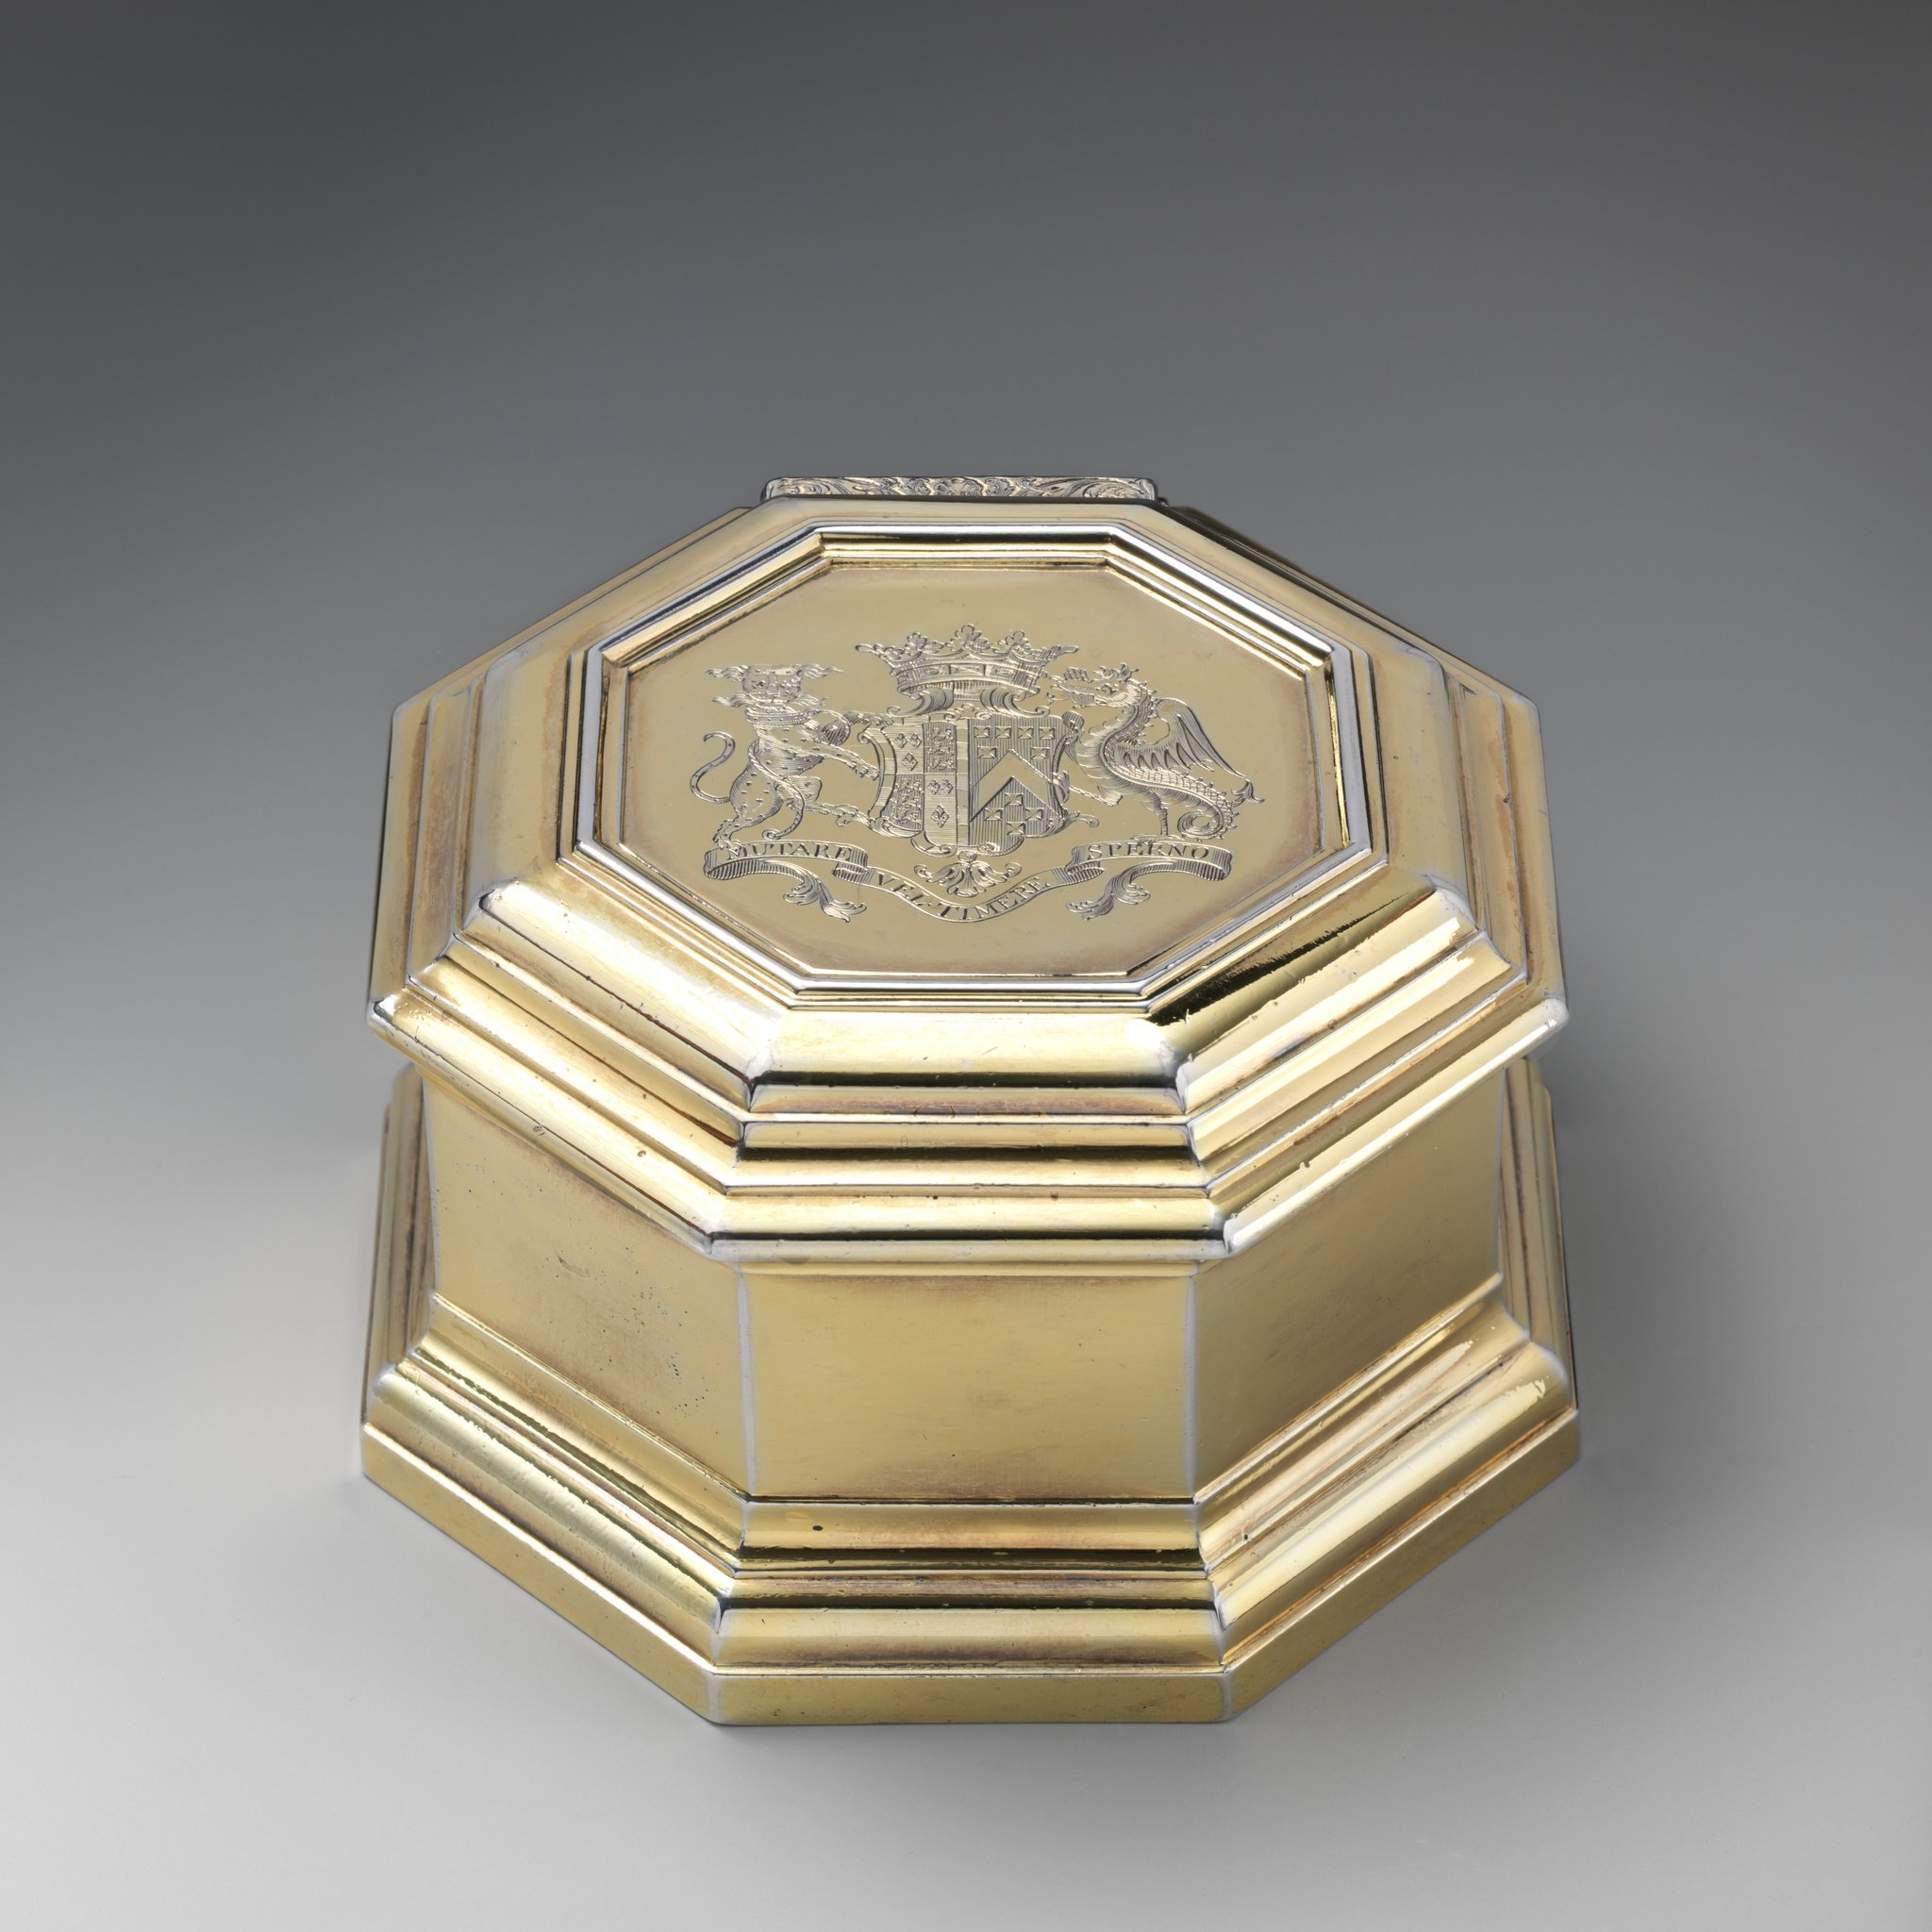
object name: box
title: Octagonal box with arms of Henry Somerset-Scudamore, 3rd Duke of Beaufort (1707–1745)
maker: john white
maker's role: maker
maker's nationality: british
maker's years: 1675-1775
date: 1729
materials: gilt silver